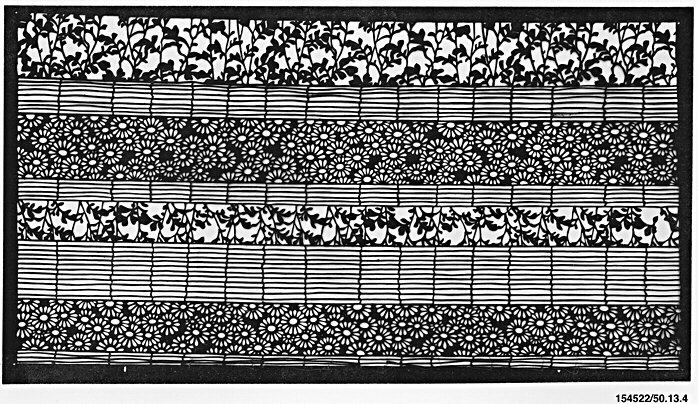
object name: stencil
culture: japanese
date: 1801-1900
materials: paper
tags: flowers